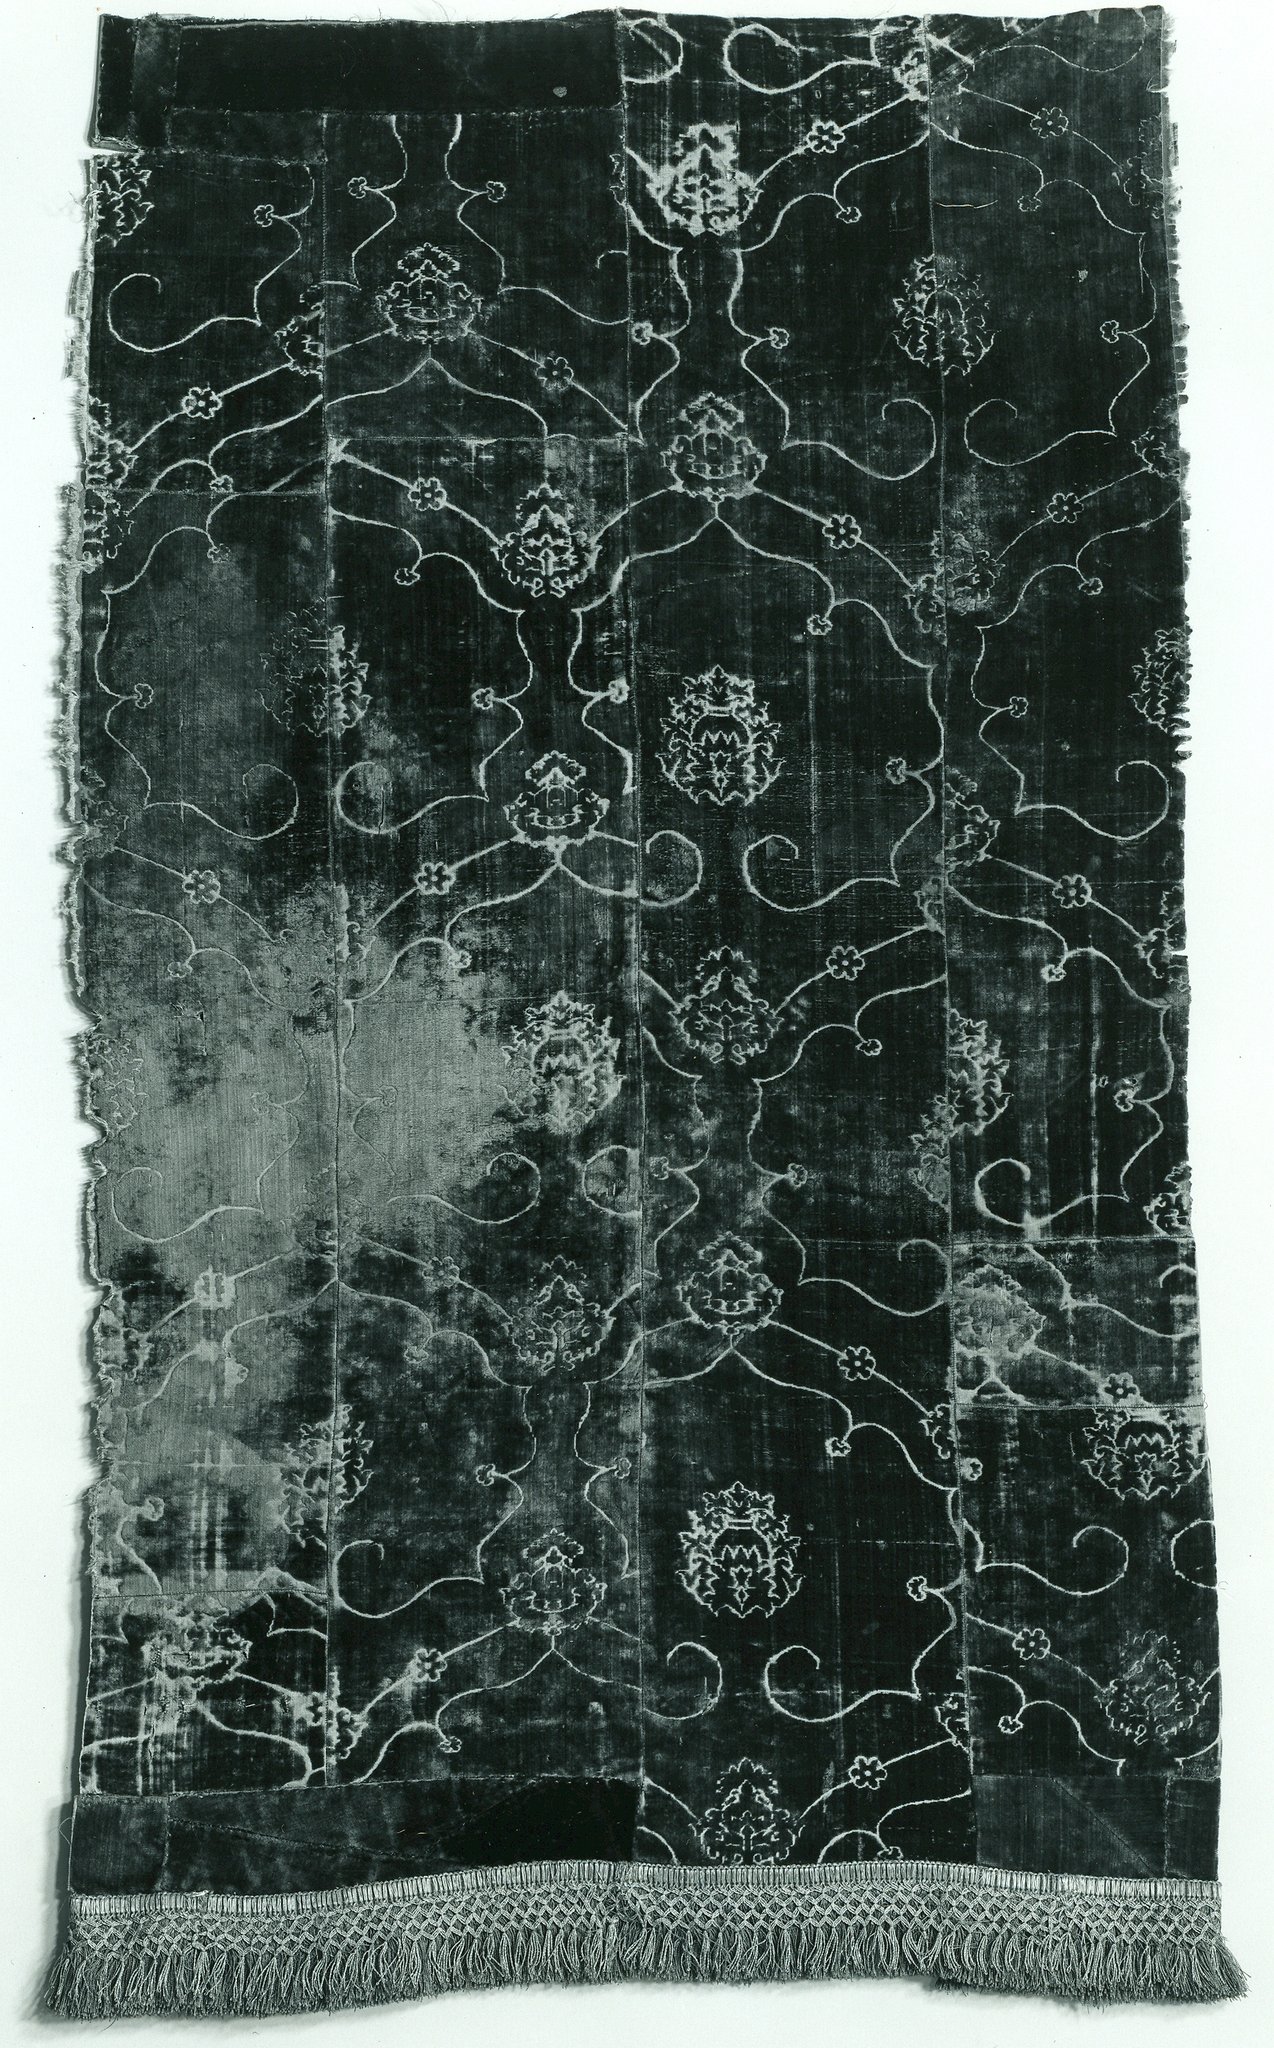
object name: textile panel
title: Panel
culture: italian or spanish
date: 1401-1500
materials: metal, silk